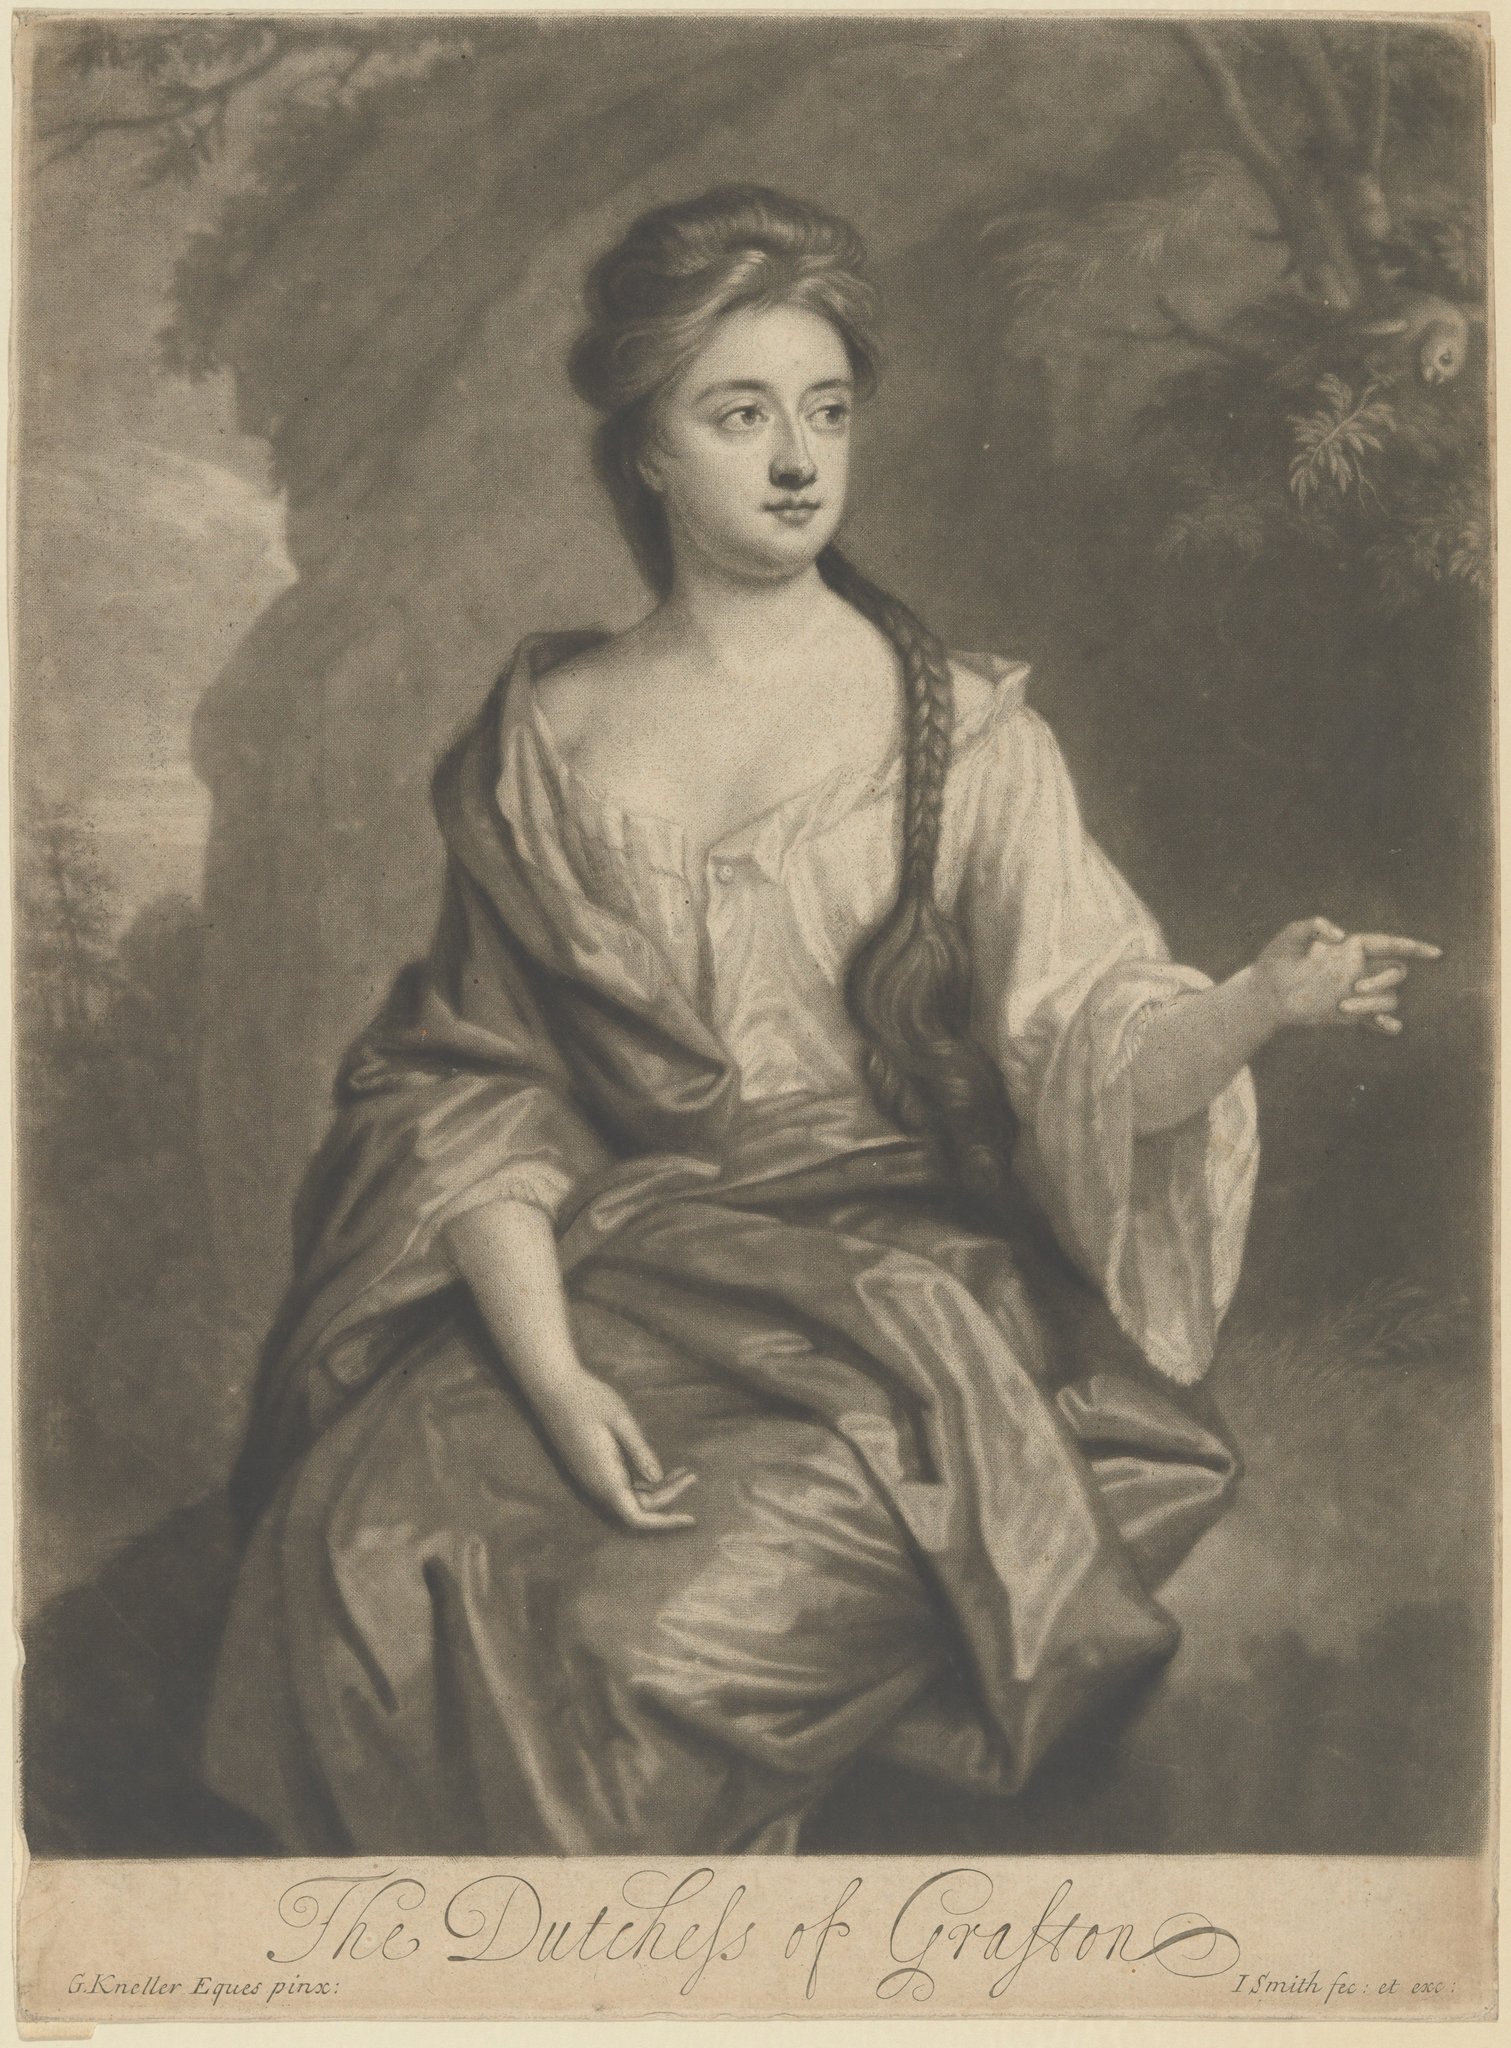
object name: print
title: Isabella, Duchess of Grafton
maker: john smith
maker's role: artist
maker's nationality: british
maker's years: 1652-1743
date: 1692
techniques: mezzotint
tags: portraits,women